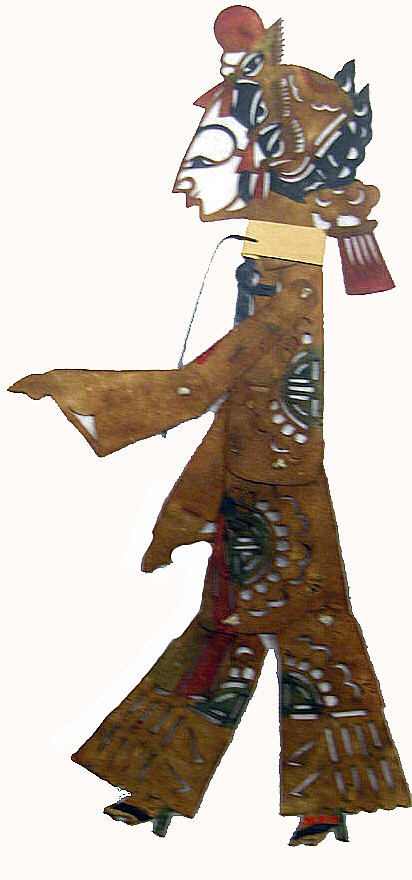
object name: shadow player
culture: chinese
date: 1801-1900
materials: cord, skin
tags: women